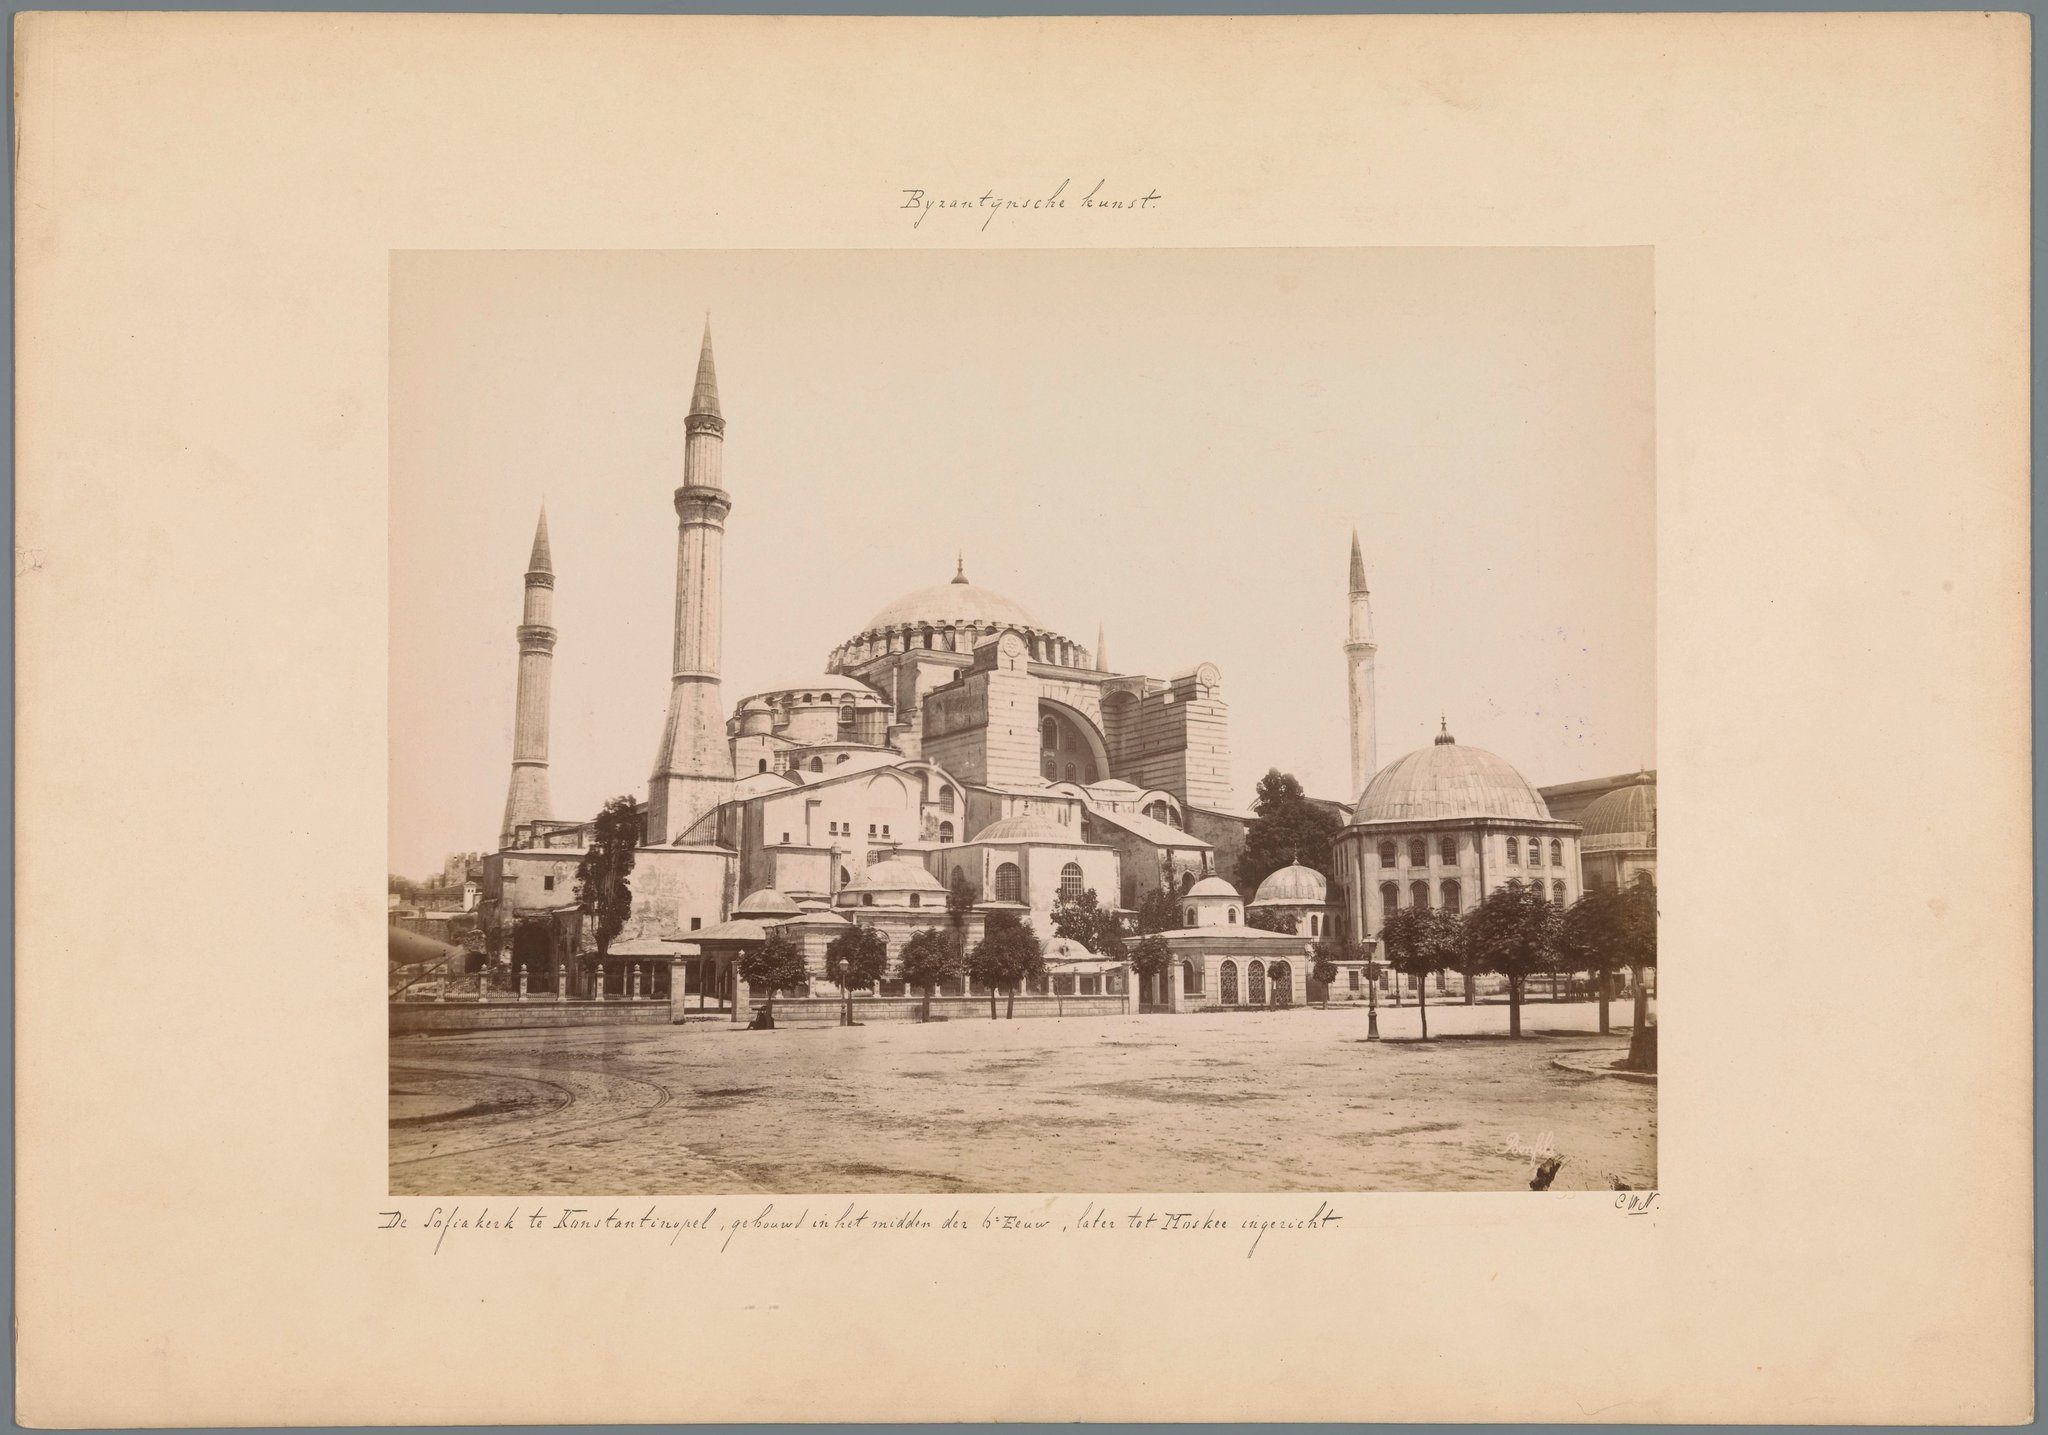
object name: photograph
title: Exterieur van de Hagia Sophia te Istanbul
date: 1875-1900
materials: cardboard, photographic support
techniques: albumen print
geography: istanbul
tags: tower, clock tower ~ monumental adornment, parts of church exterior and annexes: dome, church (exterior), temple, shrine ~ islam, mohammedanism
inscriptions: inscription: ‘CWN.’, collector's mark: ‘KUNSTNIJVERHEIDSCHOOL QUELLINUS AMSTERDAM FRANS HALSSTRAAT 14.’, inscription: ‘Byzantijnsche Kunst. De Sofiakerk te Konstantinopel, gebouwd in het midden der 6e Eeuw , later tot Moskee ingericht.’, collector's mark: ‘INSTITUUT VOOR KUNST- NIJVERHEIDSONDERWIJS GABRIËL METSUSTRAAT No. 16. AMSTERDAM’